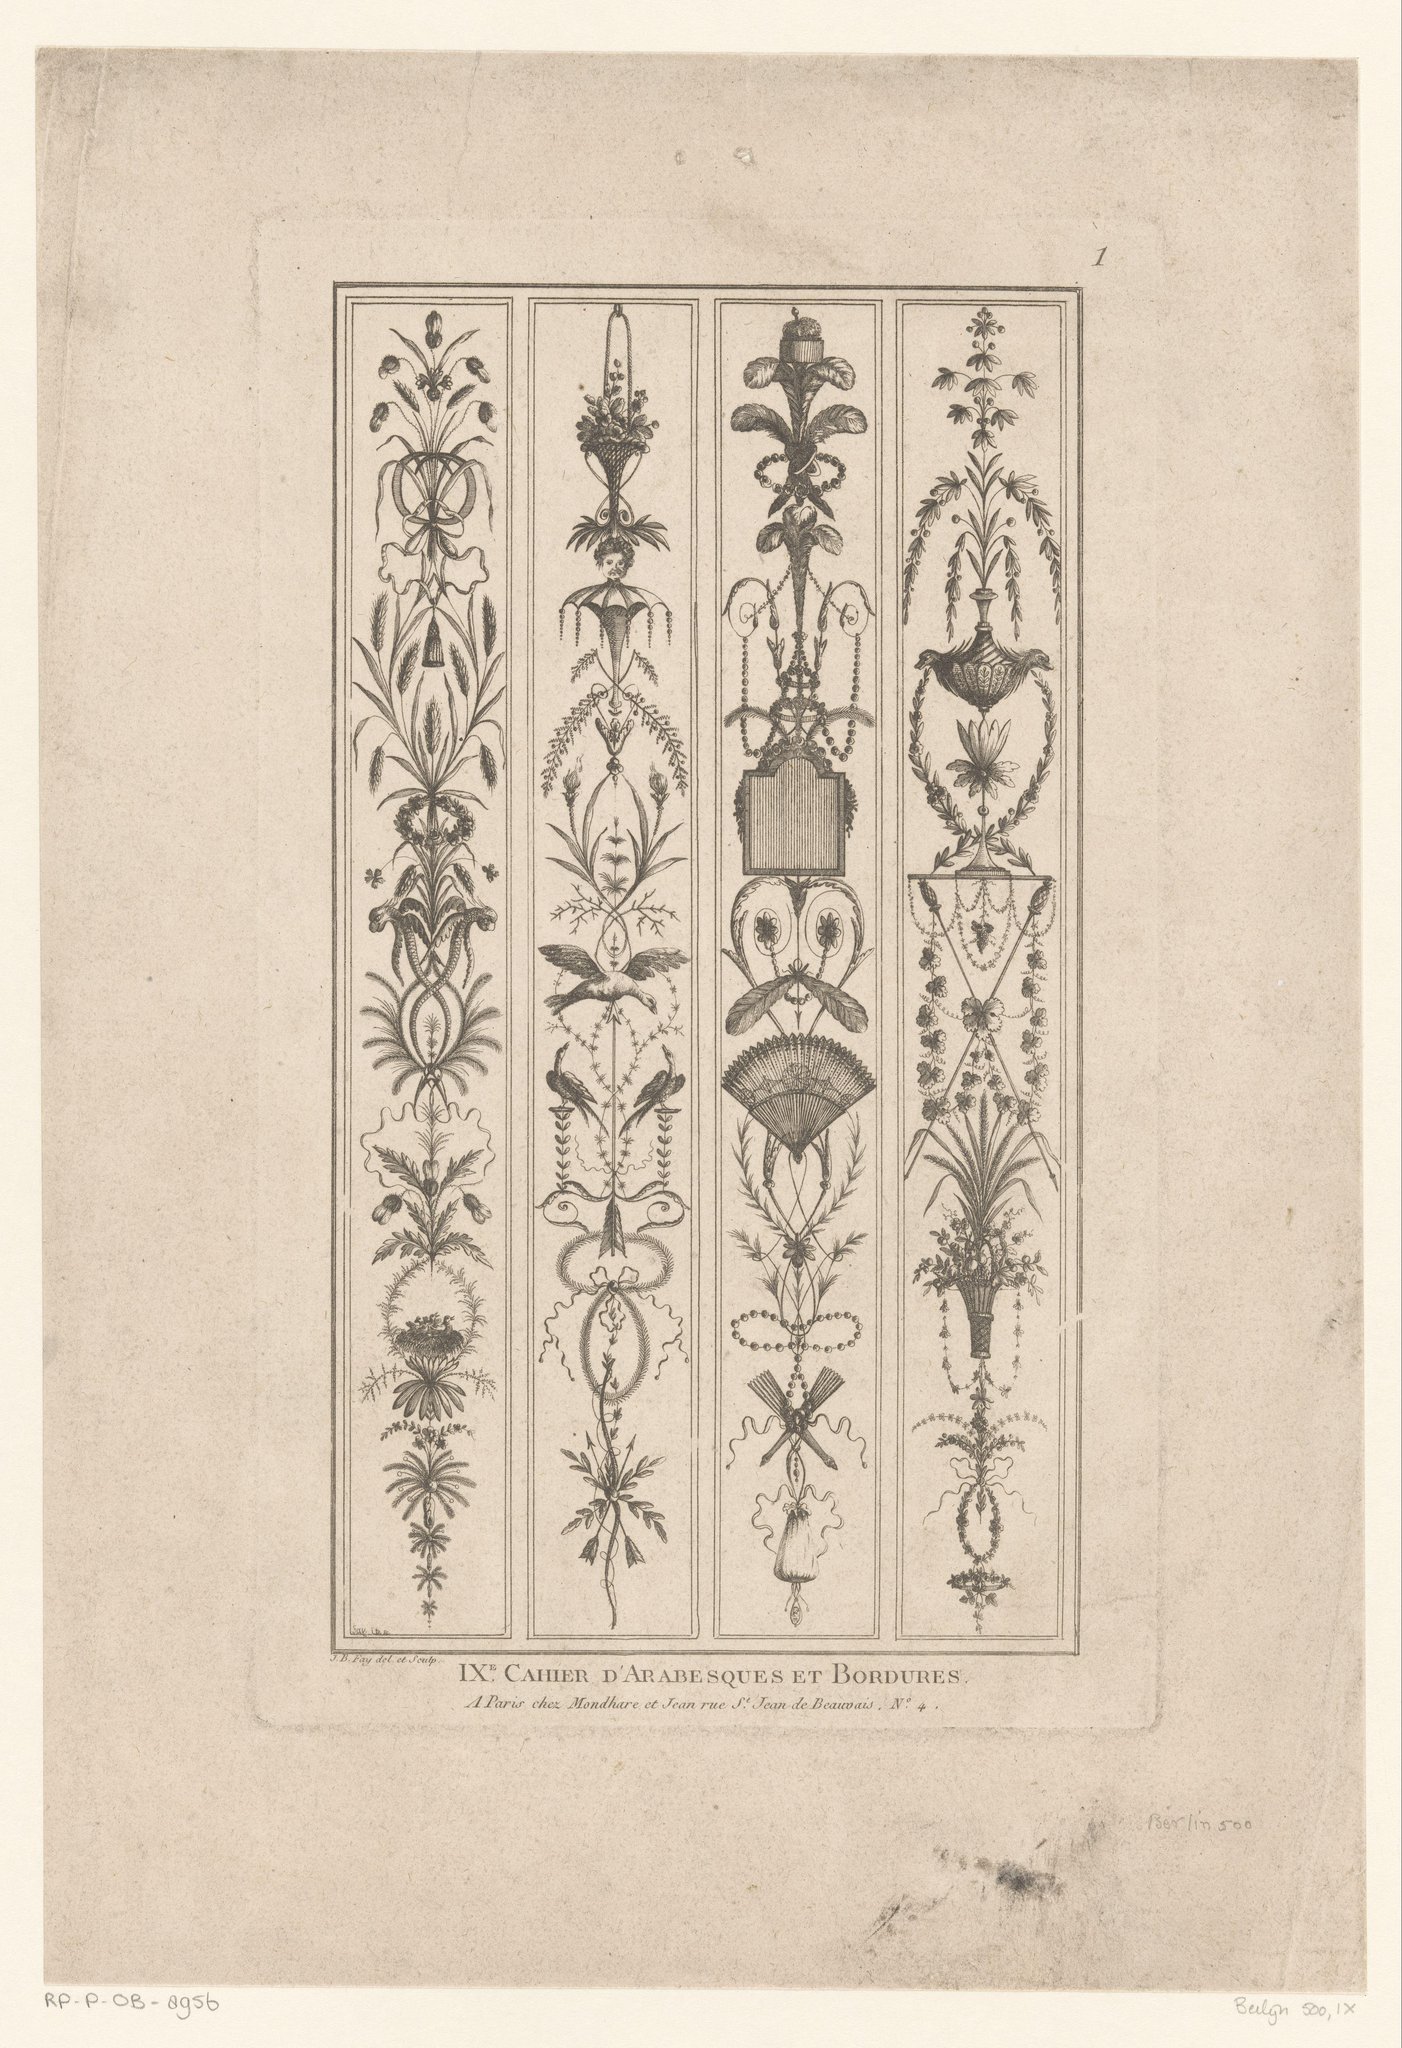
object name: ornament print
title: IXe Cahier d'Arabesques et Bordures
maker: jean baptiste fay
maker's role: print maker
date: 1784-1796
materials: paper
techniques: engraving, etching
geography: paris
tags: ornament ~ arabesque, birds, vase ~ ornament, fan, agricultural implements: sickle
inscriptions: collector's mark: Lugt 2228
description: Vier verticale panelen met arabesken en sikkels, aren, vogels, spiegel, waaier en vazen.